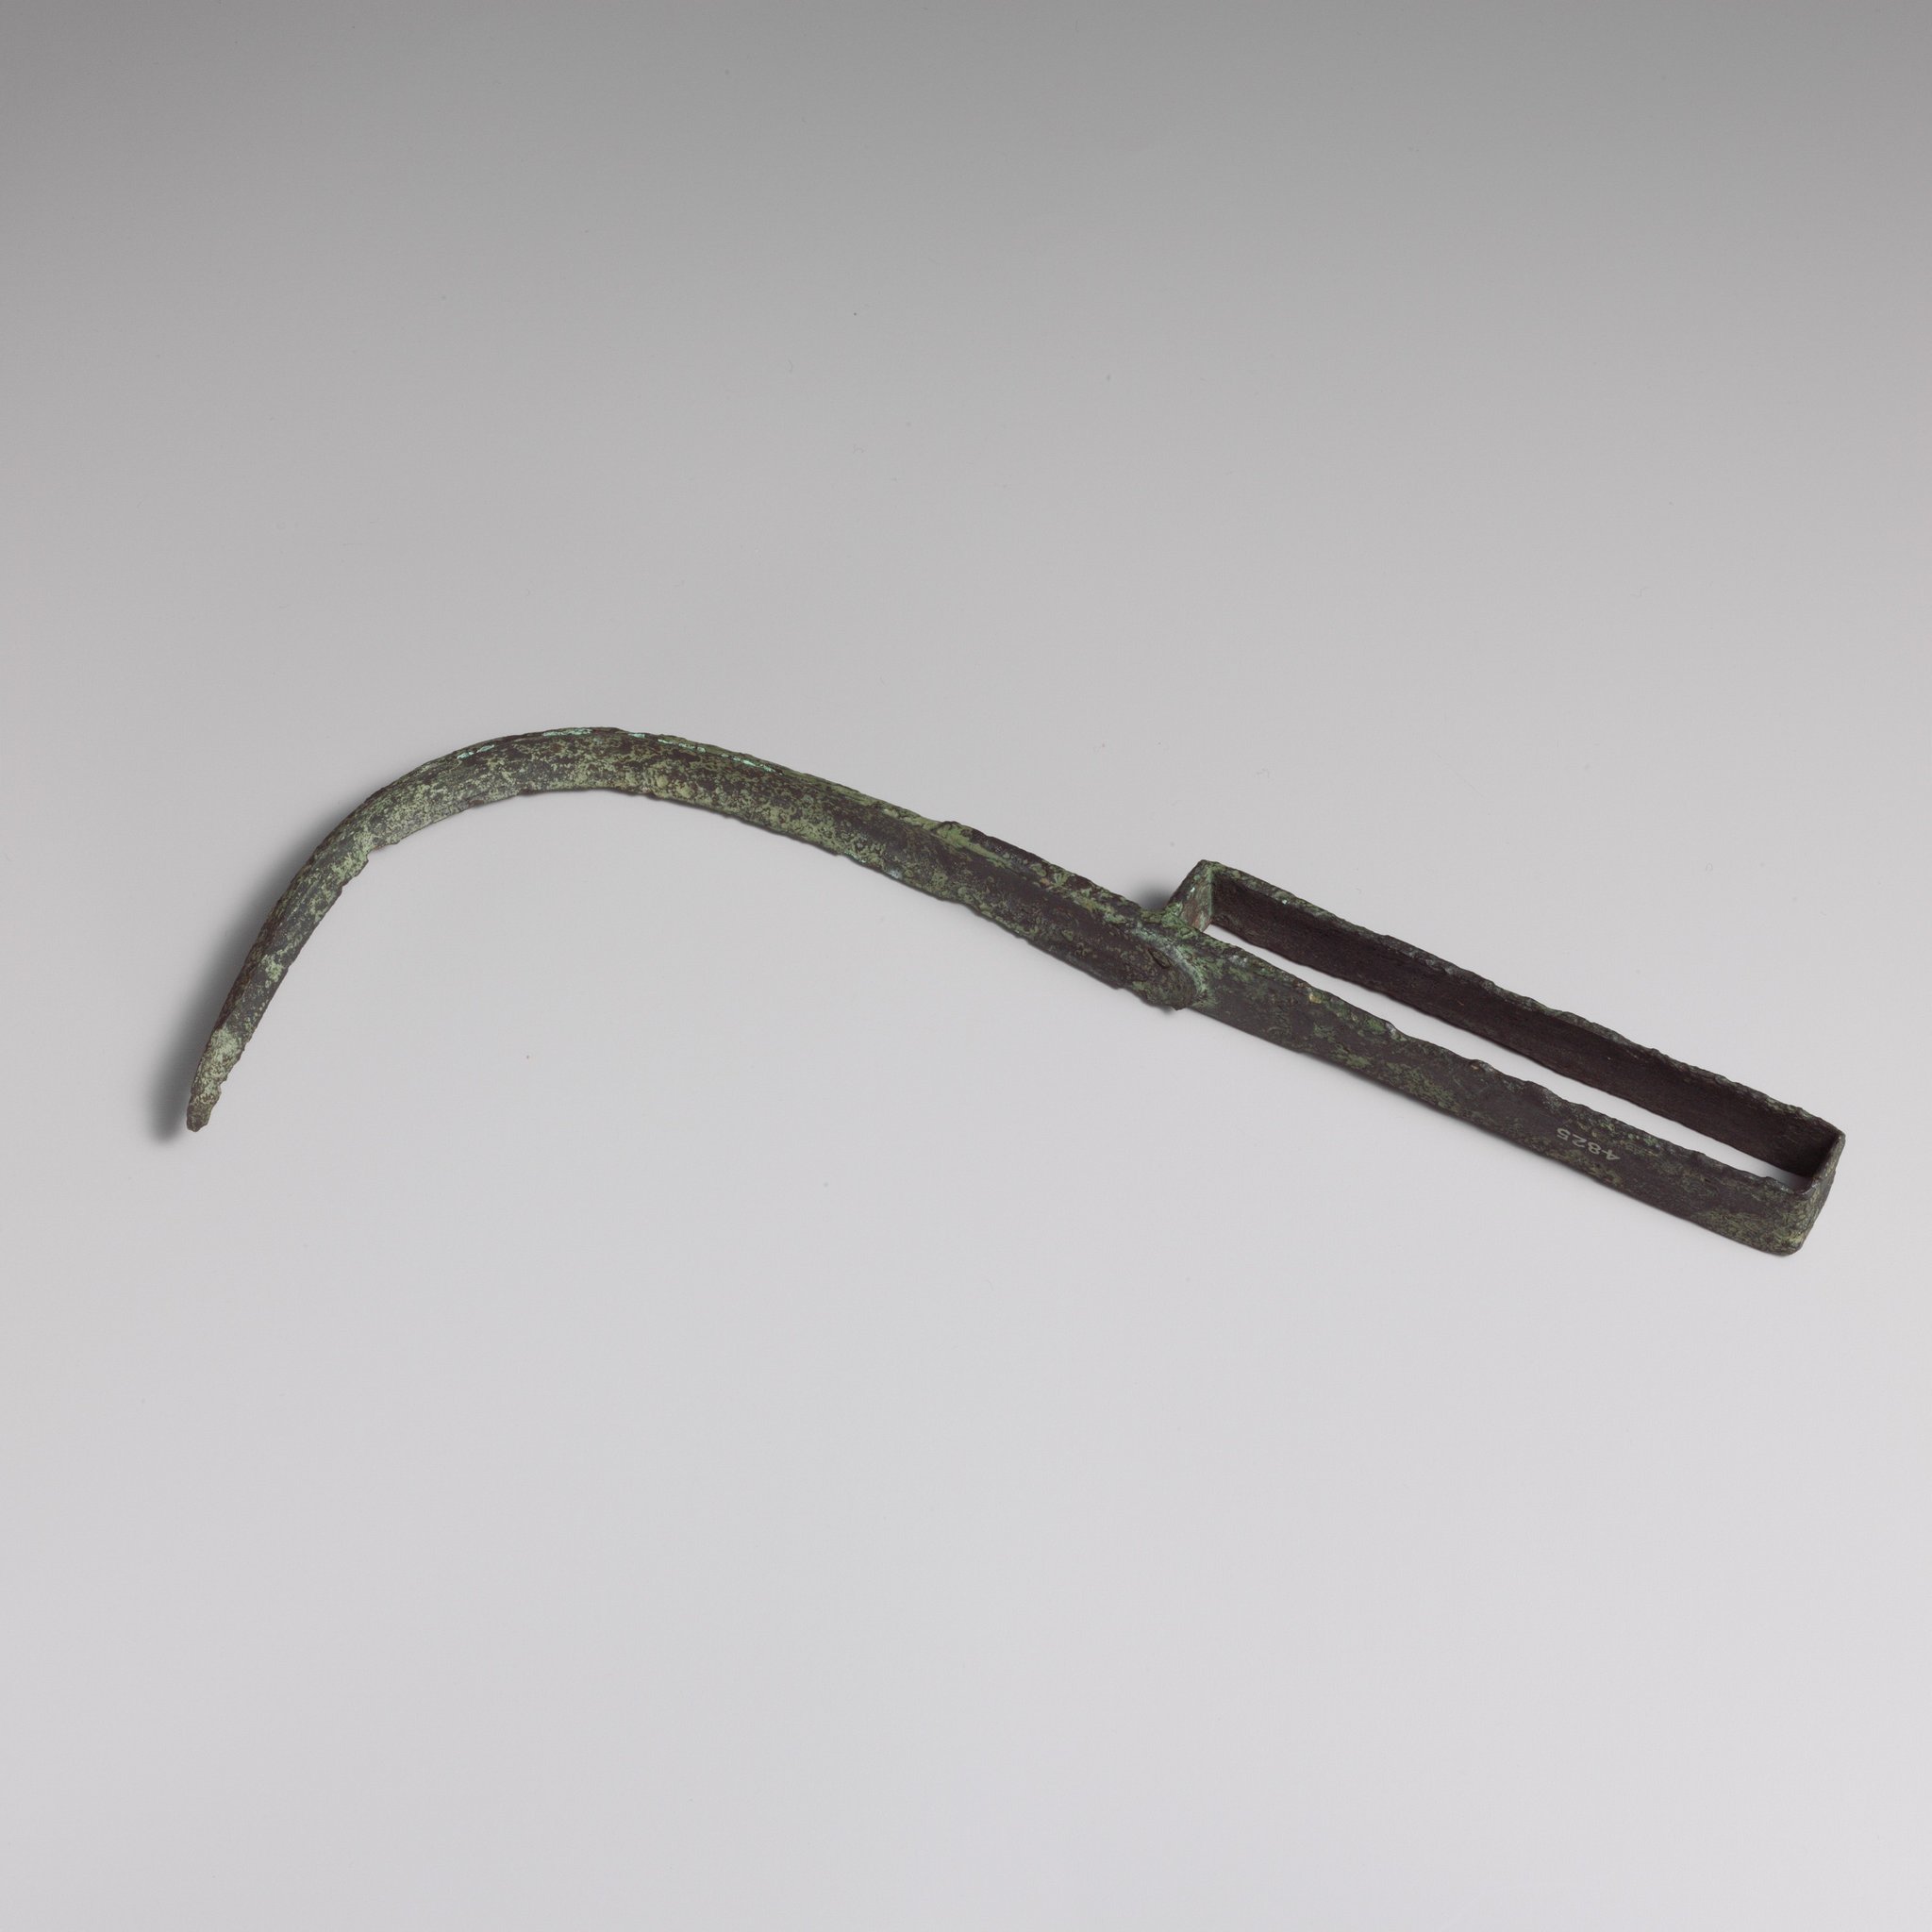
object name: strigil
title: Bronze strigil (scraper)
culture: roman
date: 1-100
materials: bronze